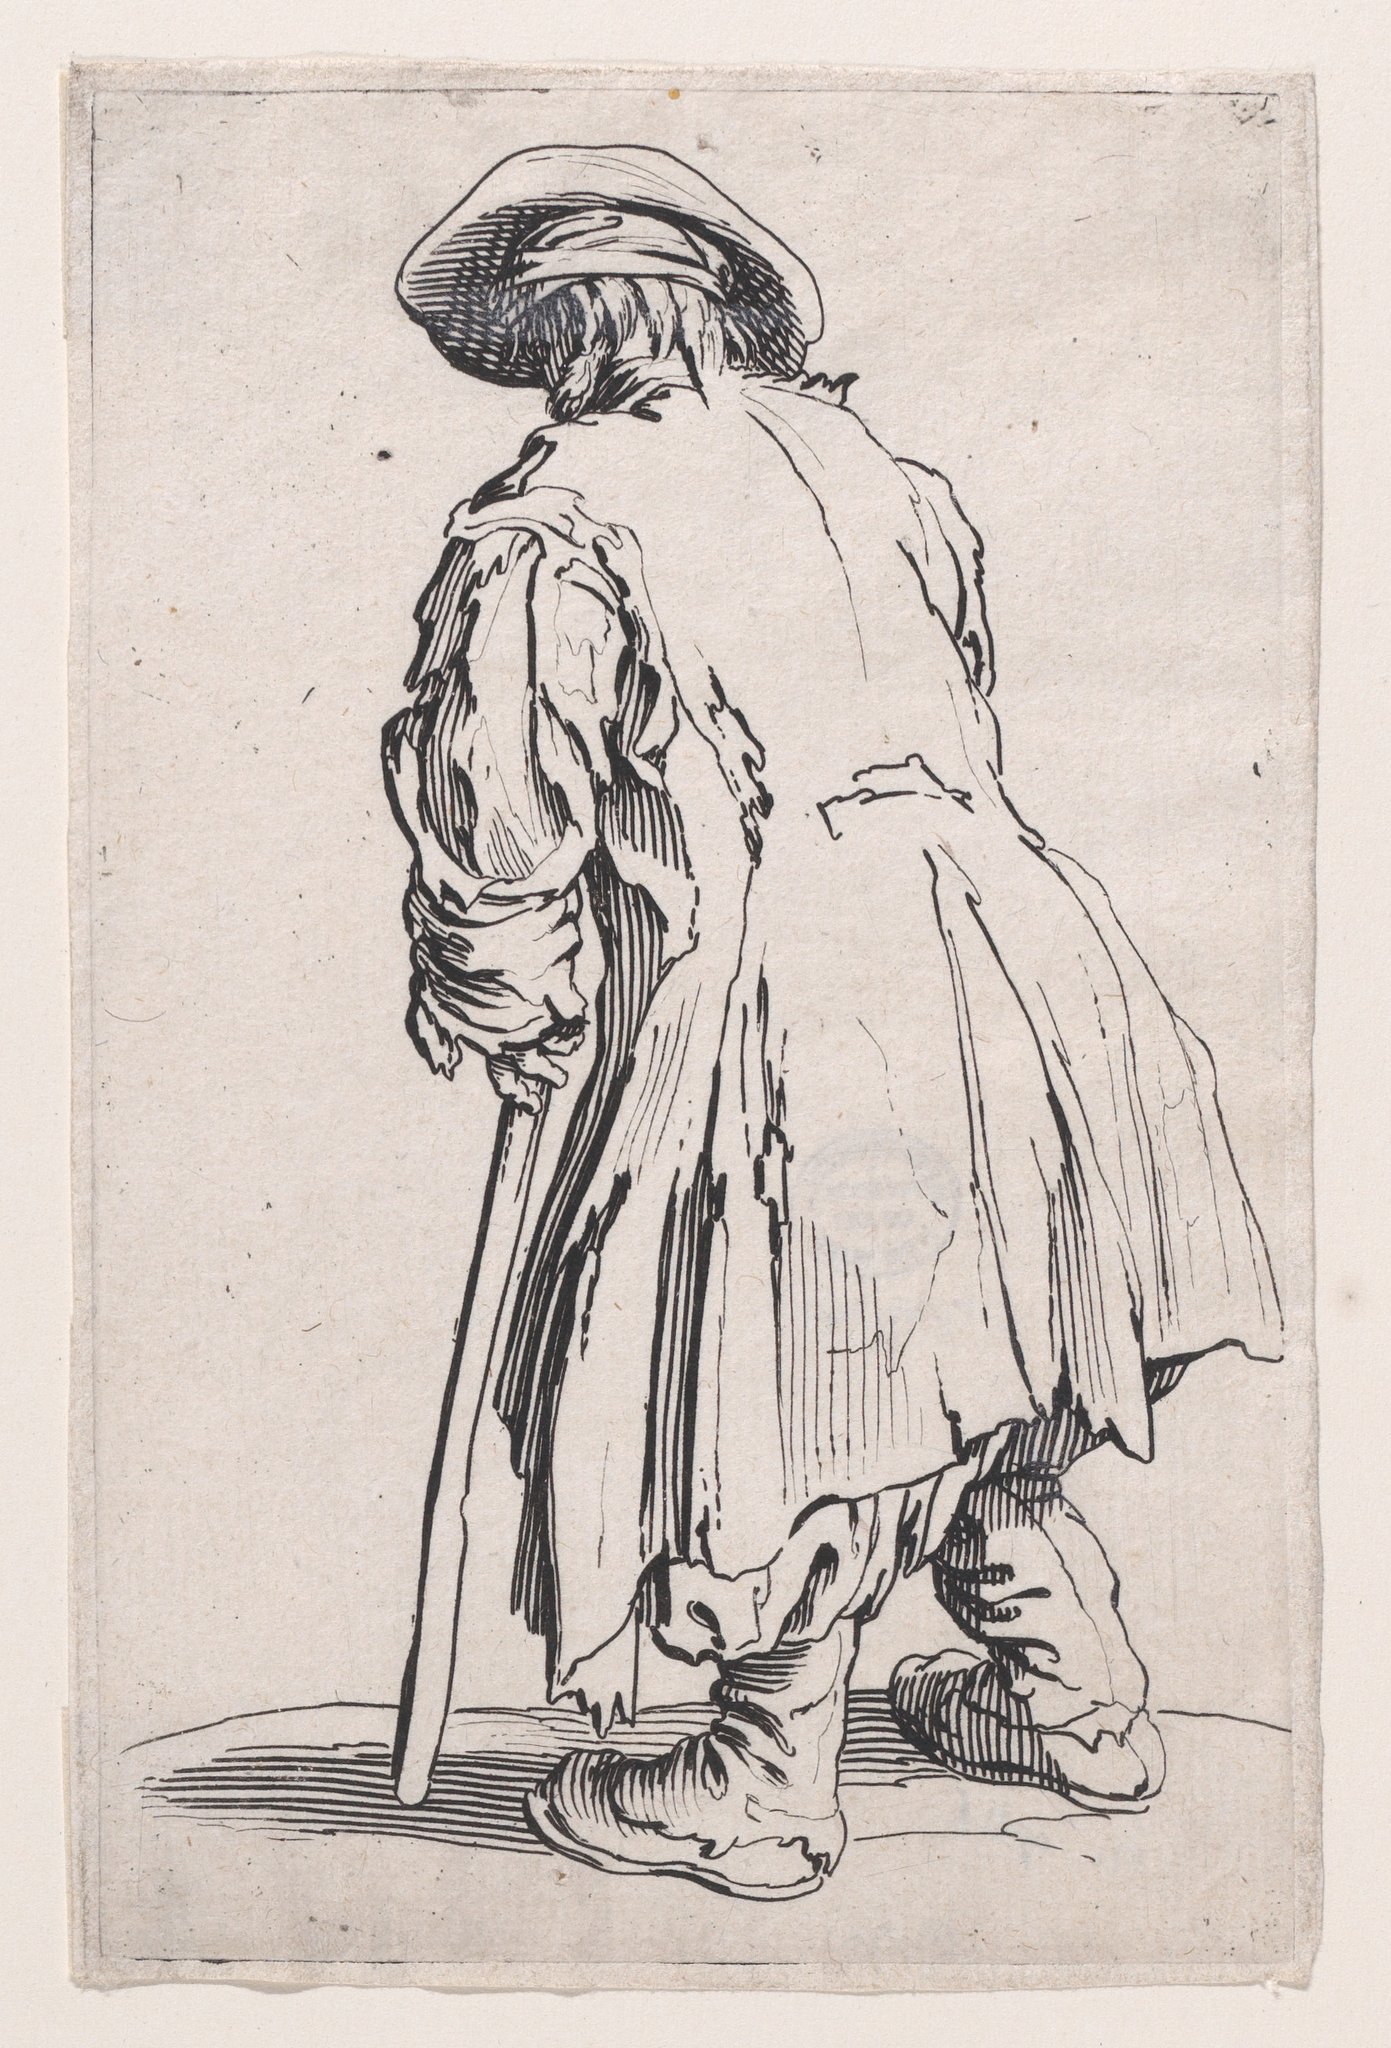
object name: print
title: La Vieux Mendiant a une Seule Béquille (The Old Beggar with Only One Crutch), from "Les Gueux suite appelée aussi Les Mendiants, Les Baroni, ou Les Barons" (The Beggars, also called the Barons)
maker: jacques callot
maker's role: artist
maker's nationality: french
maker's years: 1592-1635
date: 1623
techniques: etching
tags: men